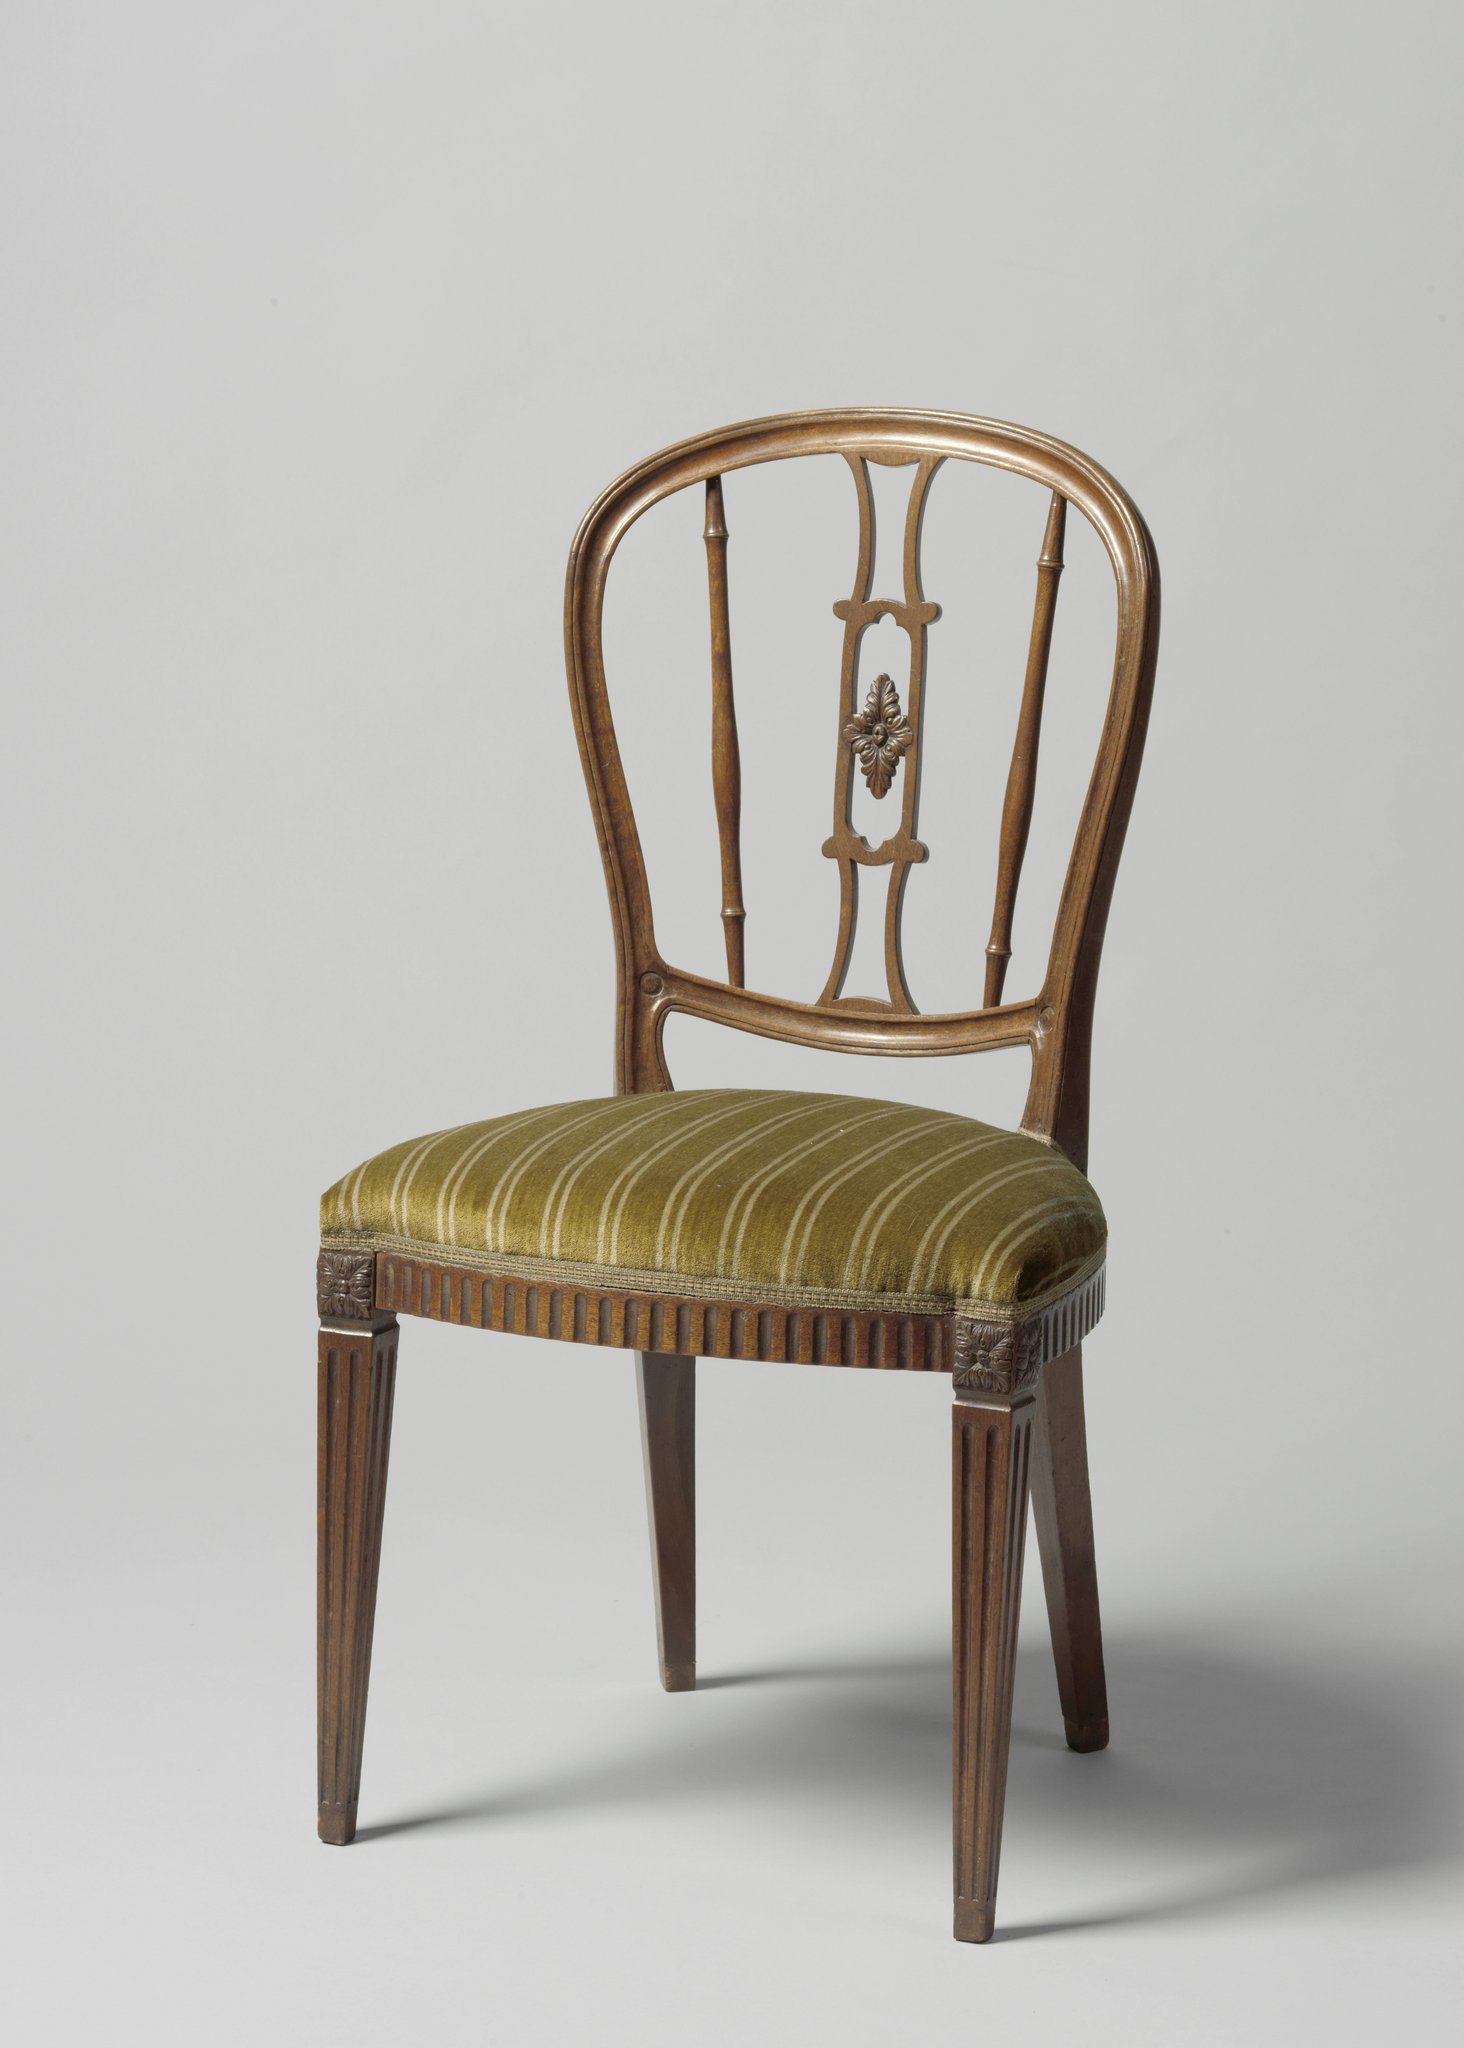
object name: seating furniture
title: Meubilair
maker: Anonymous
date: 1775-1800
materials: wood, textile, velvet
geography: northern netherlands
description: Chair. Mahogany, the upholstery renewed. Netherlands, 4th quarter of the 18th century. Given by Mrs M. Brandt and Mrs D. Brandt.